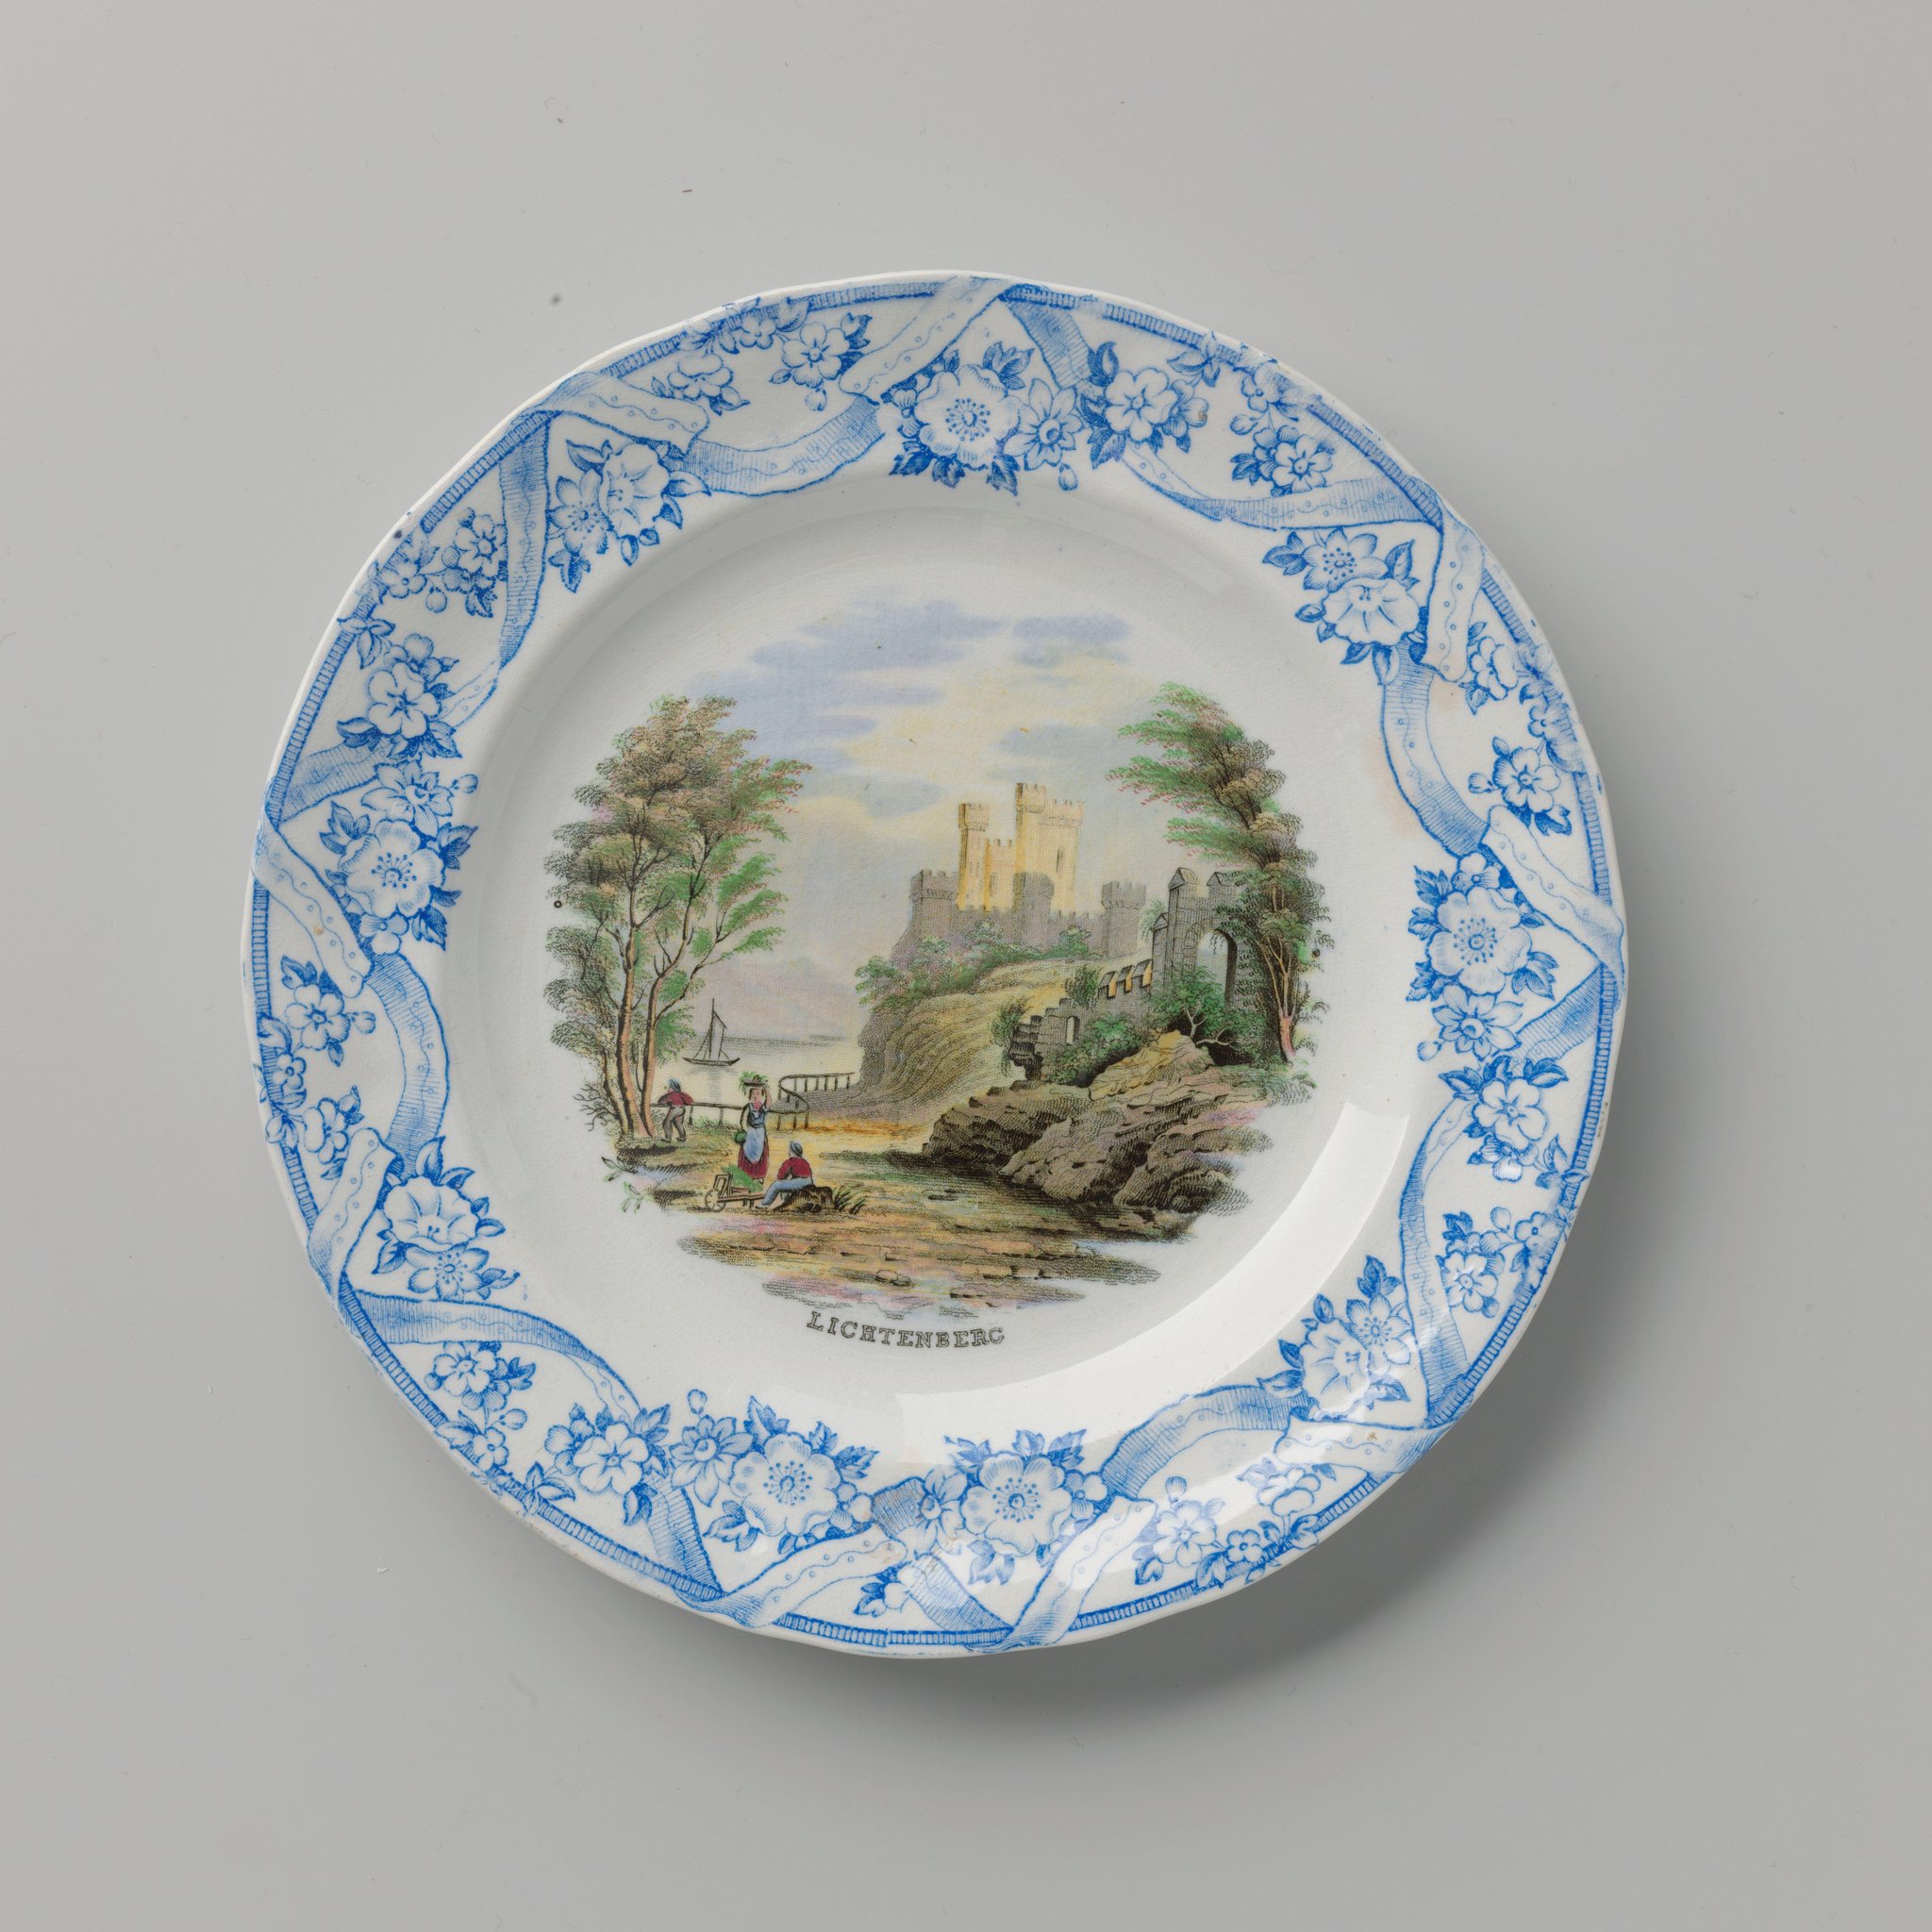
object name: plate dish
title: Bord, met op het plat een kasteel en een ruïne, en enkele mensen langs een rivier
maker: petrus regout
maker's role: plateelbakker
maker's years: 1801-1879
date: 1860-1890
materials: creamware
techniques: transfer decoration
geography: maastricht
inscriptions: check stamp: ‘Bijenkorf // P. REGOUT // MAASTRICHT en 12’, mark: ‘Staffordshire knot // 1851 // PRIZE MEDAL // P.REGOUT . MAASTRICHT’, inscription: ‘LICHTENBERG’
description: Bord van aardewerk met veelkleurig transferdecor. Op het plat een kasteel en een ruïne, en enkele mensen langs een rivier. Onder de voorstelling de tekst: "LICHTENBERG". De rand van het bord is gedecoreerd in blauw met een band waaraan guirlandes en een lint hangen.